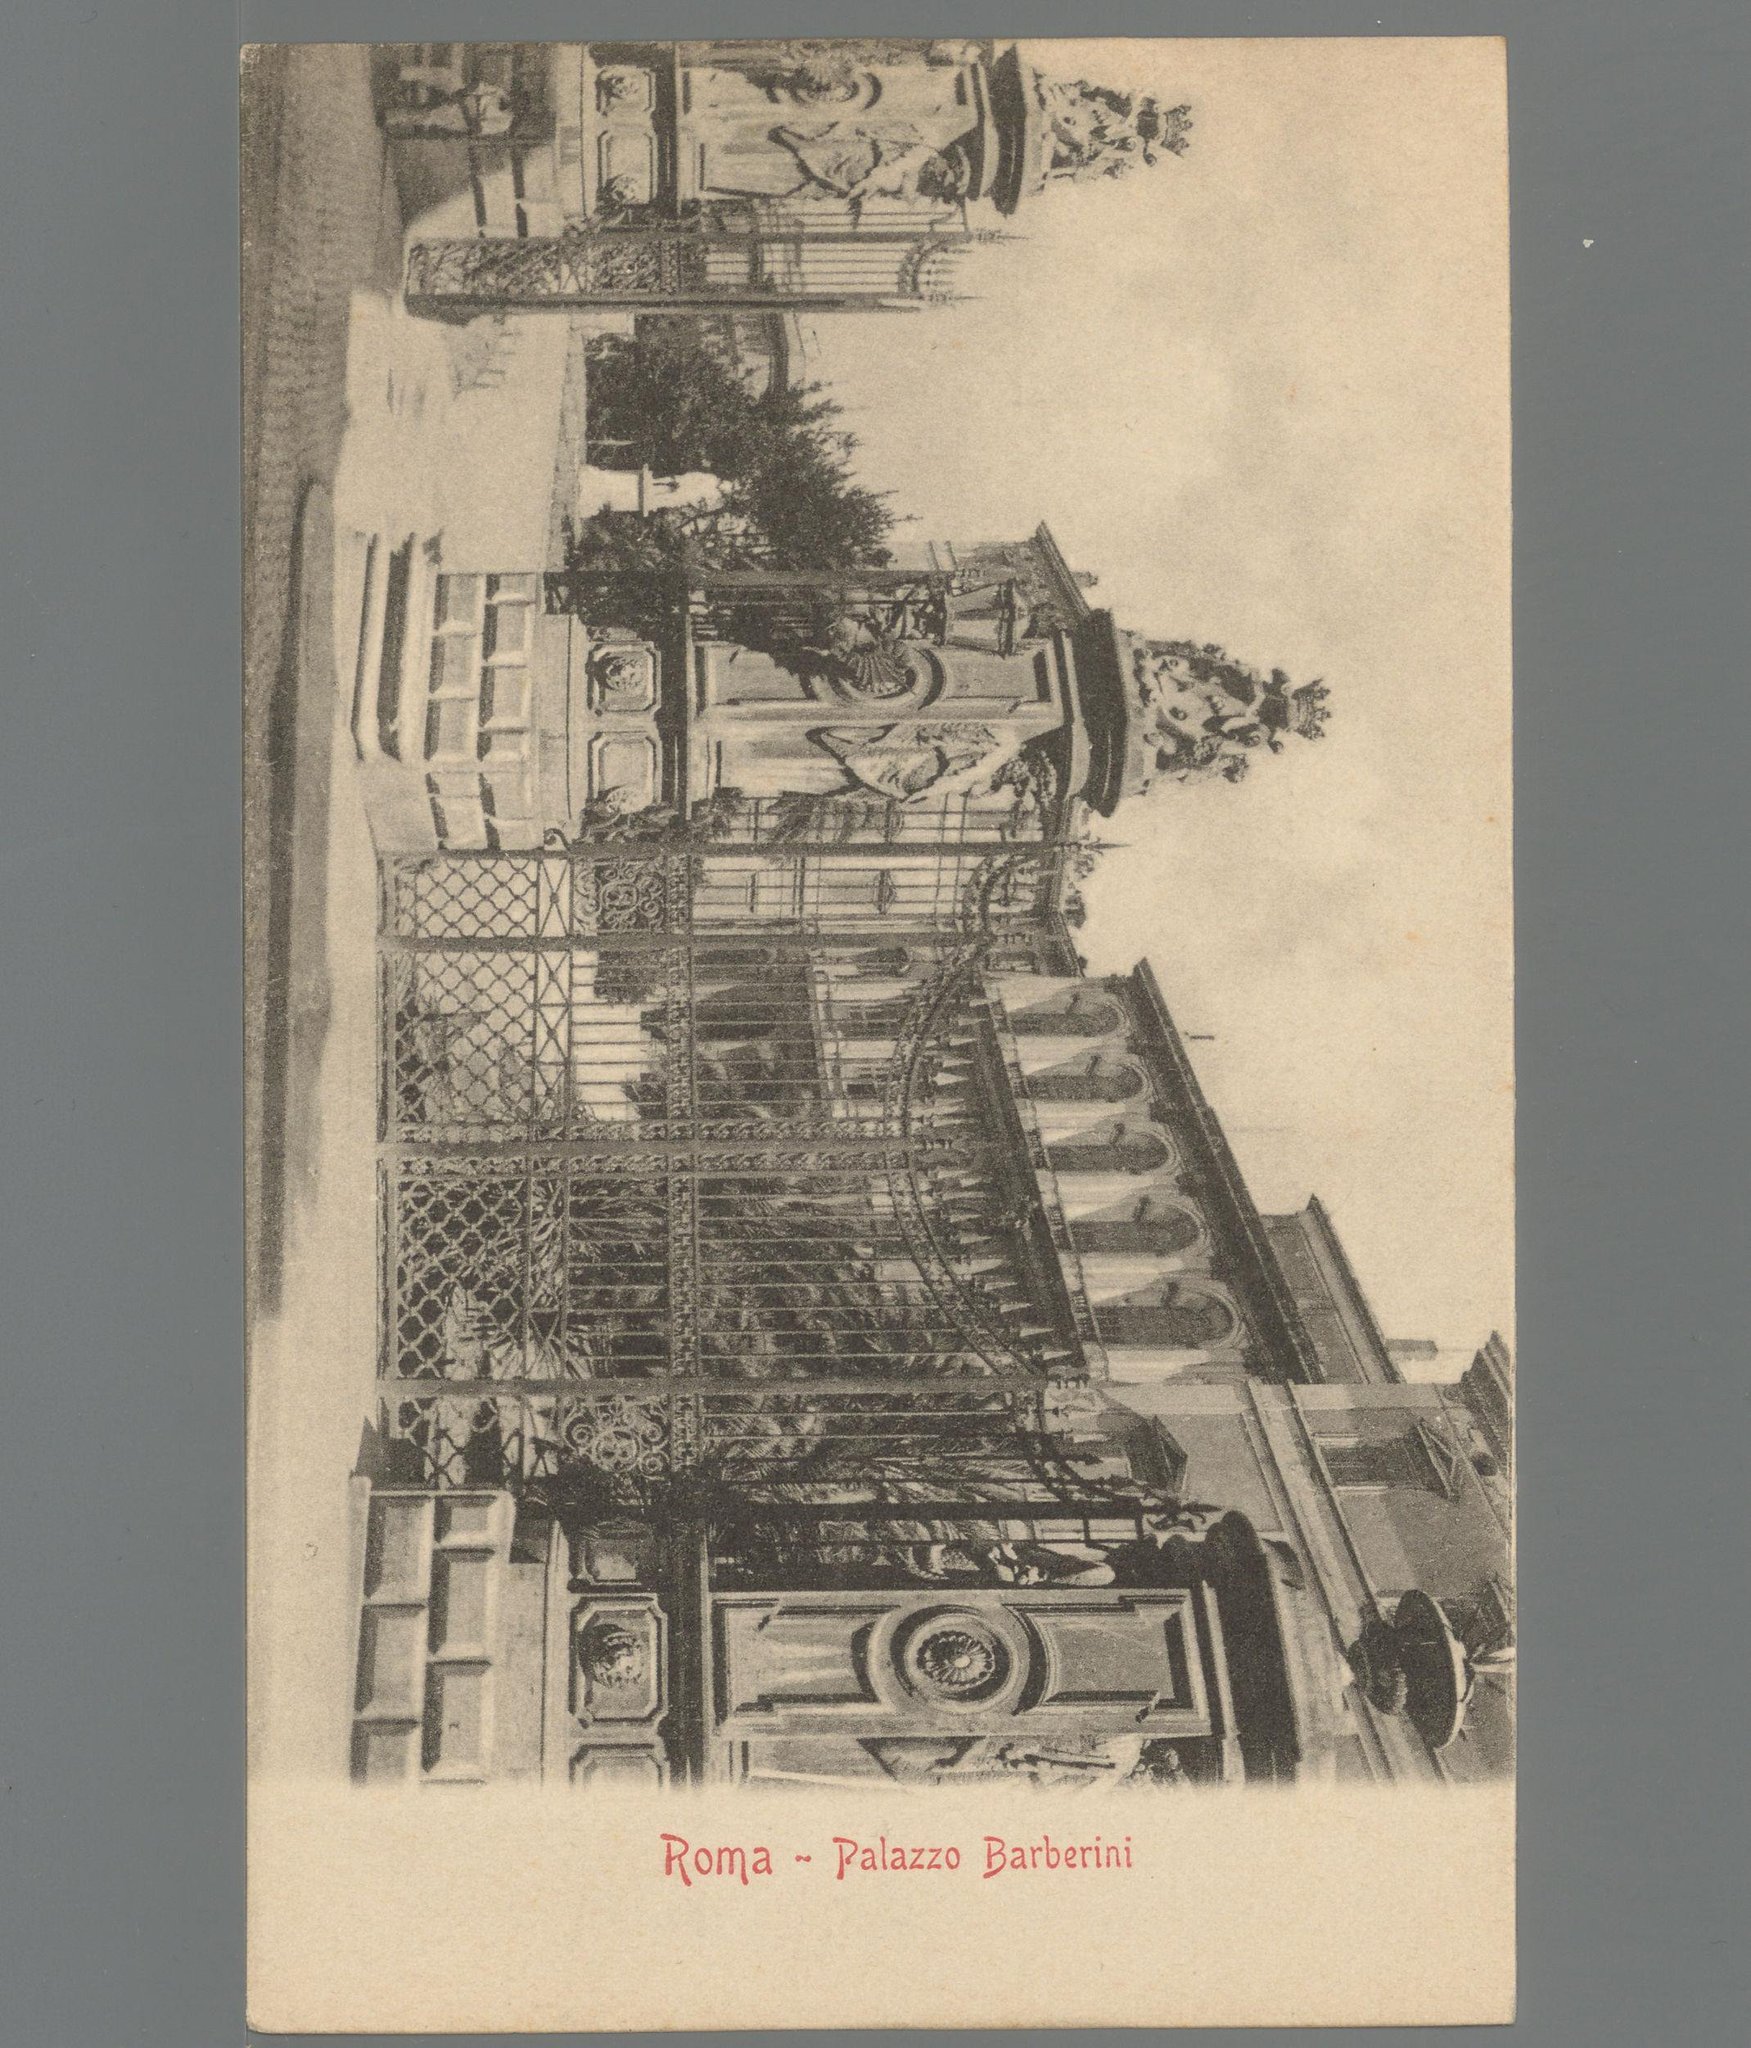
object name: photomechanical print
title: Roma. Palazzo Barberini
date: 1889-1906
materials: cardboard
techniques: photograph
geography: rome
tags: palace, gate, entrance